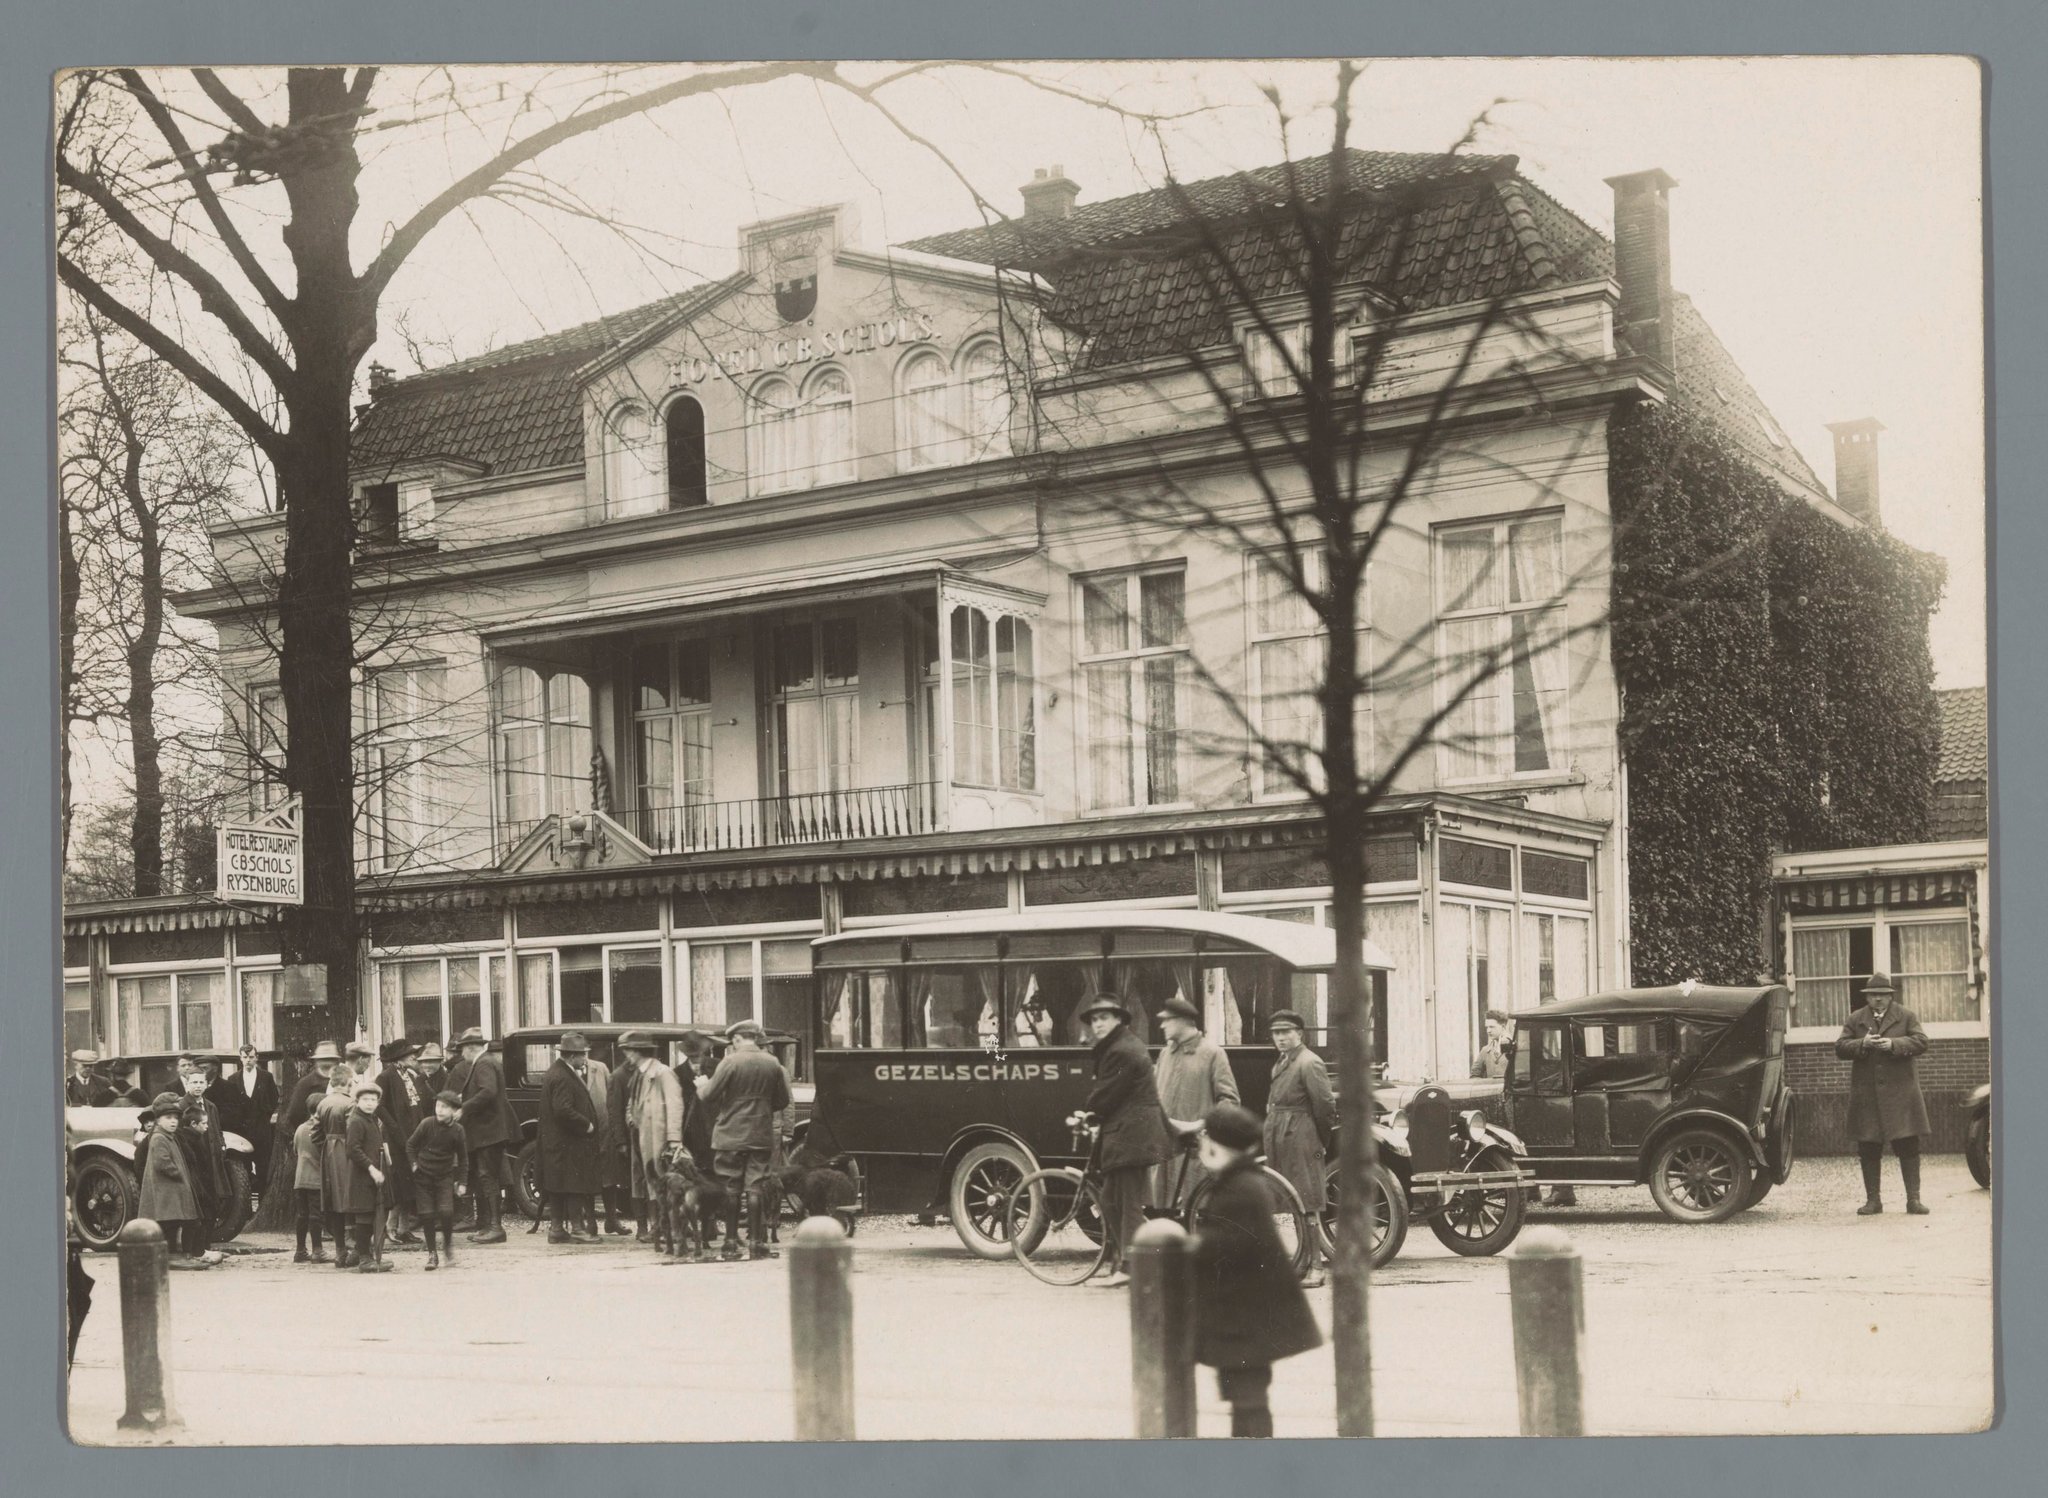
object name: photograph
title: Exterieur van Hotel Schols te Driebergen-Rijsenburg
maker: jacobus hendrik spoormaker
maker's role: fotograaf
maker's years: 1860-1944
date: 1927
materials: photographic support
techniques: gelatin silver print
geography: driebergen-rijsenburg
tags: façade (of house or building), automobile, hotel, hostelry, inn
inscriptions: name: ‘J. H. Spoormaker. Driebergen.’, inscription: ‘8. April. 1927’